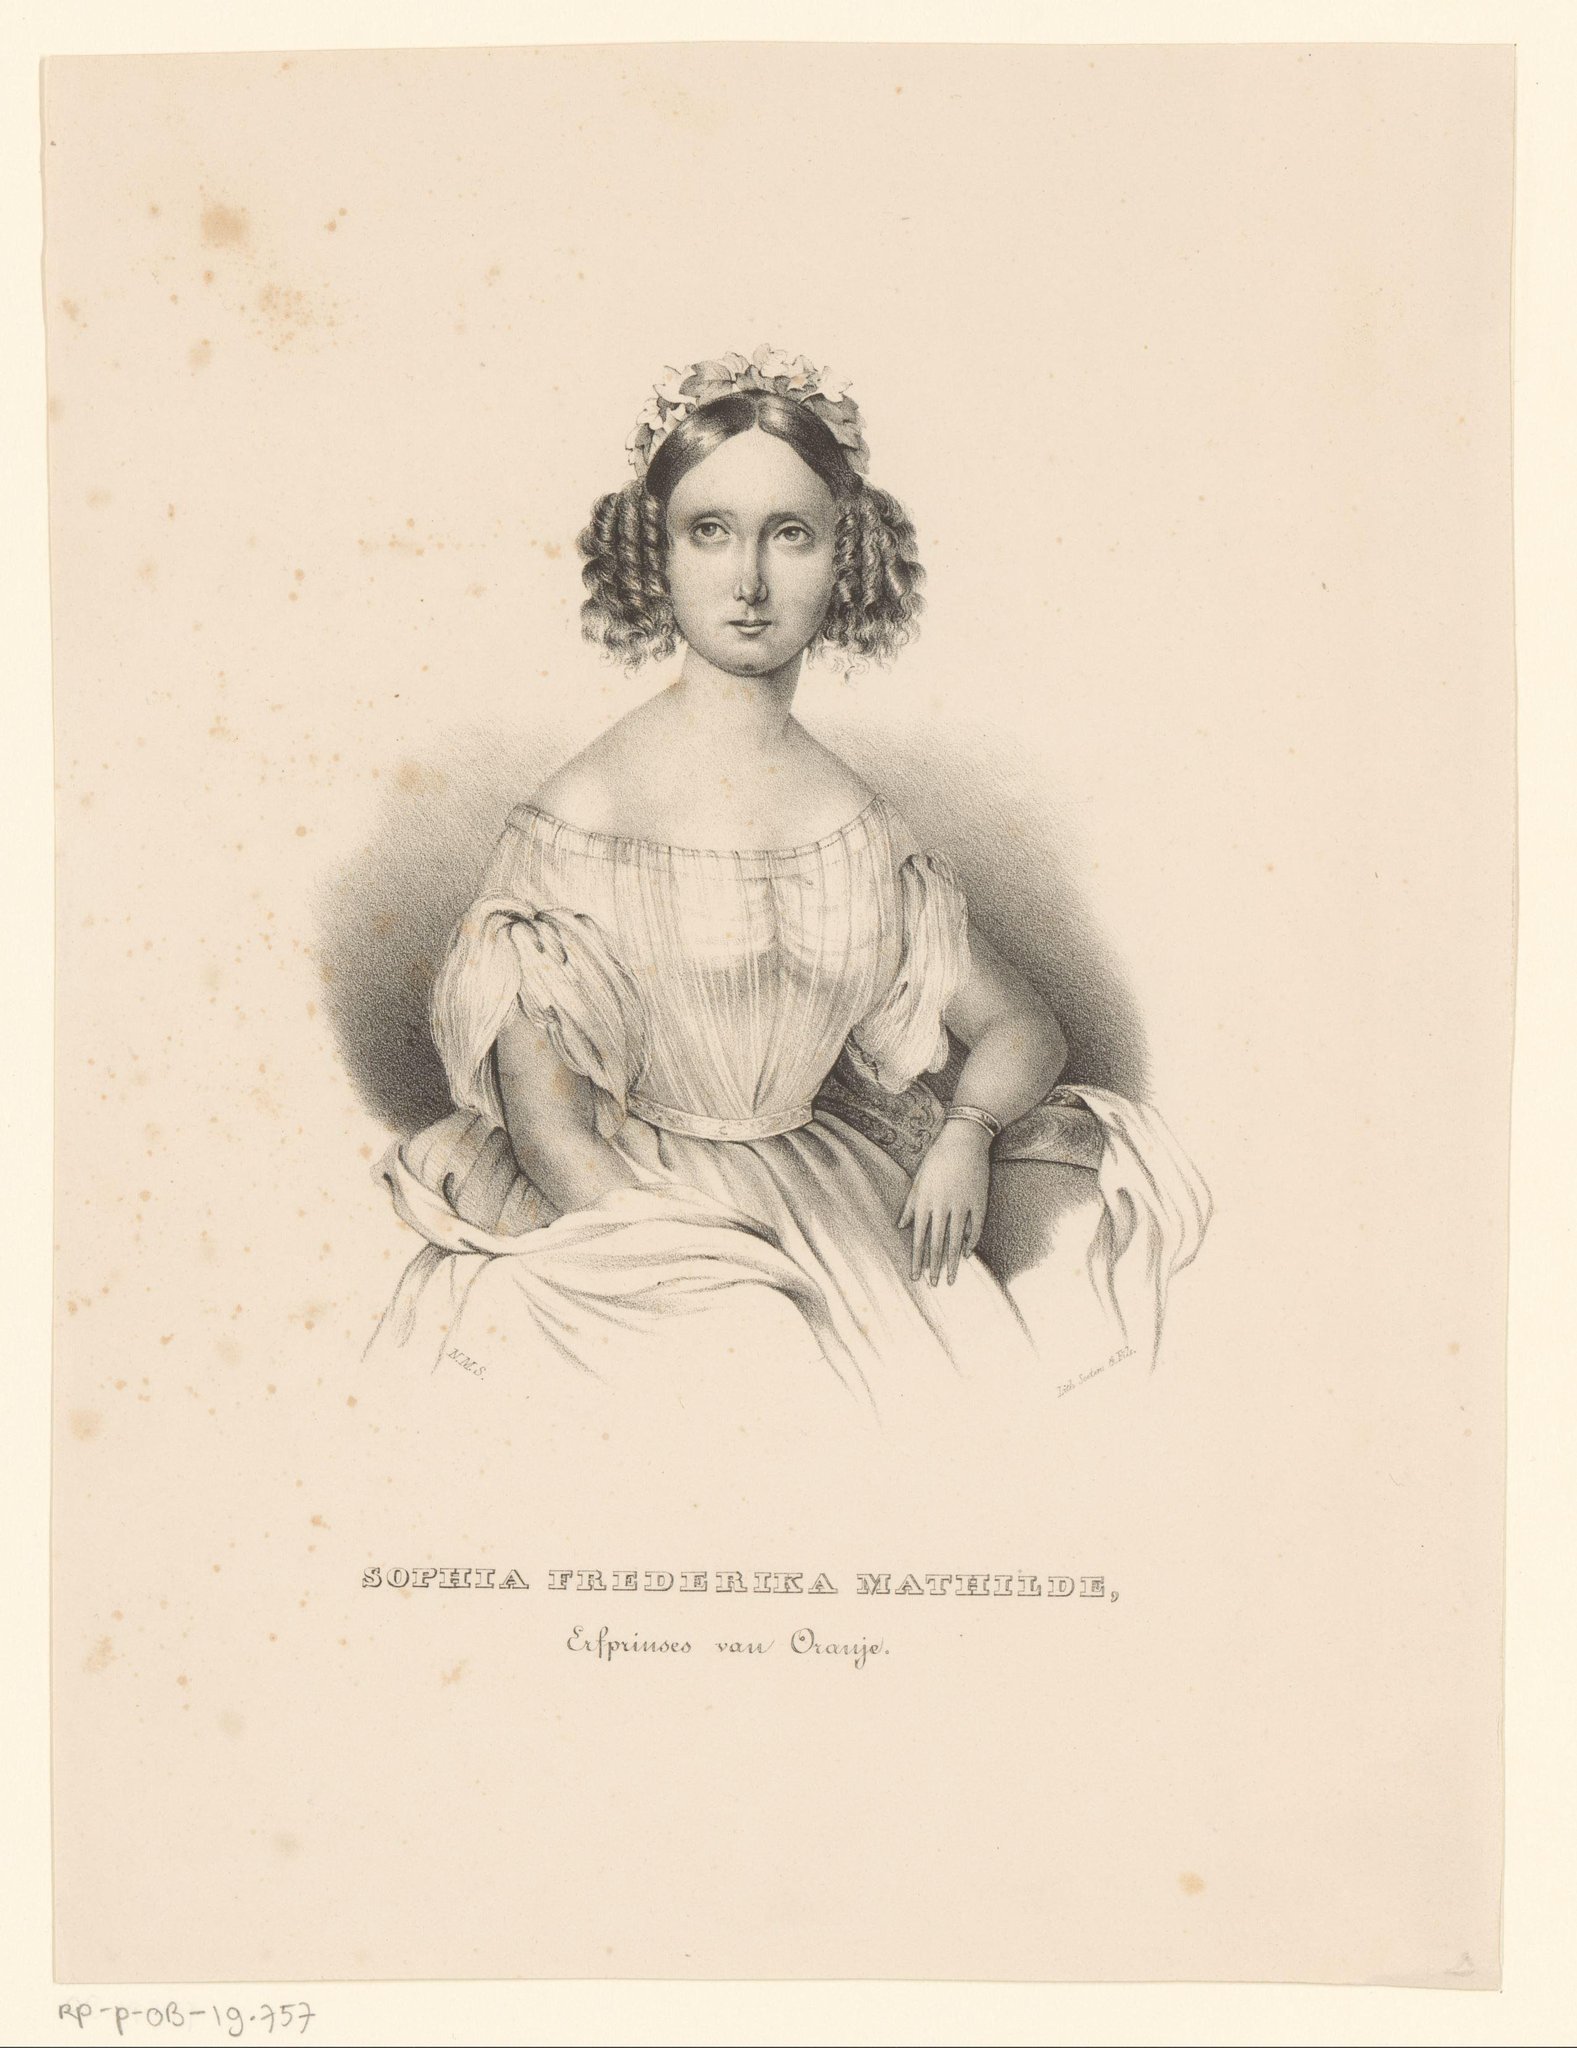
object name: print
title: Portret van Sophie van Wurtemberg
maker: nicolaas martinus schild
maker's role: draughtsman, print maker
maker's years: 1822-1840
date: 1837-1840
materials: paper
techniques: lithograph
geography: the hague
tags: the hague, sophia frederika mathilda van württemberg, historical persons (+ (full) bust portrait)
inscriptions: collector's mark: Lugt 2228